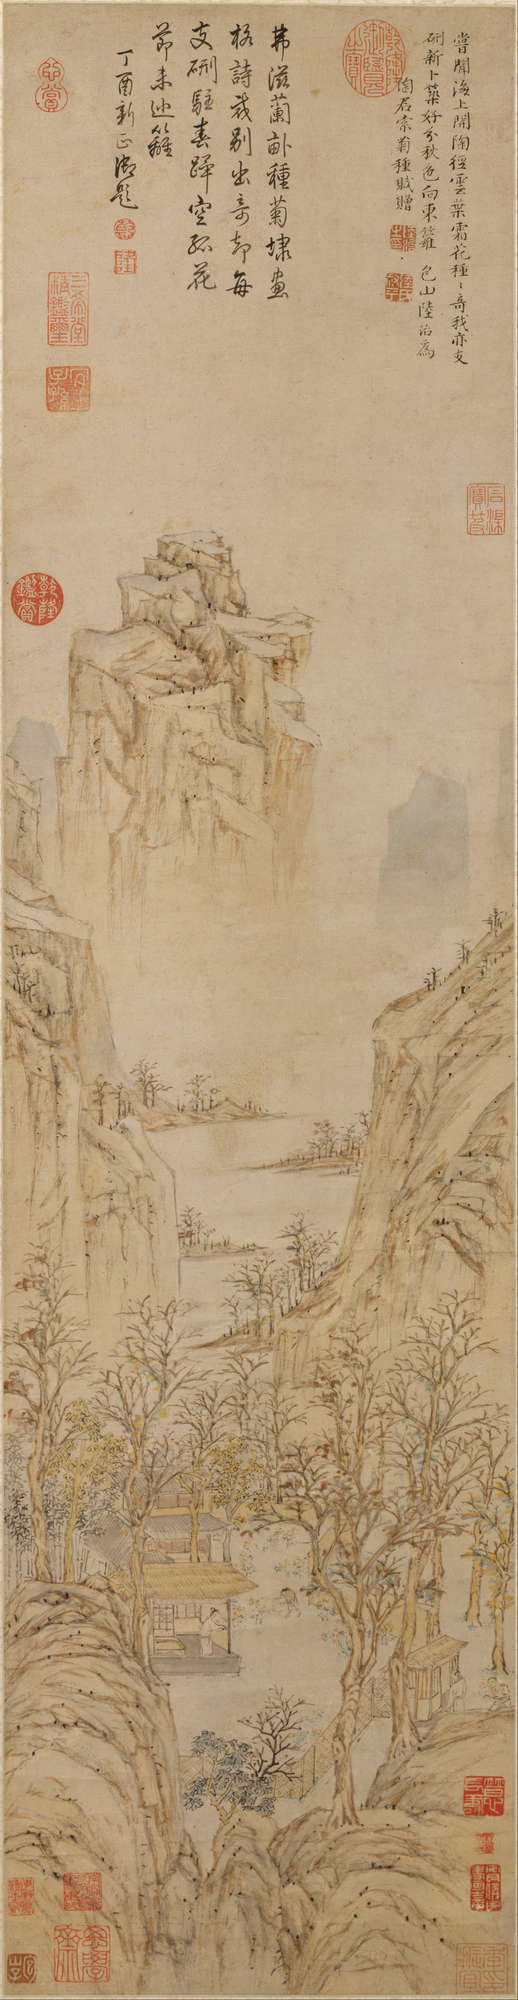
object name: hanging scroll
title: Planting Chrysanthemums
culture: chinese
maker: lu zhi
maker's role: artist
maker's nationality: chinese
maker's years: 1495-1576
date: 1501-1600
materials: ink, paper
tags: mountains,landscapes